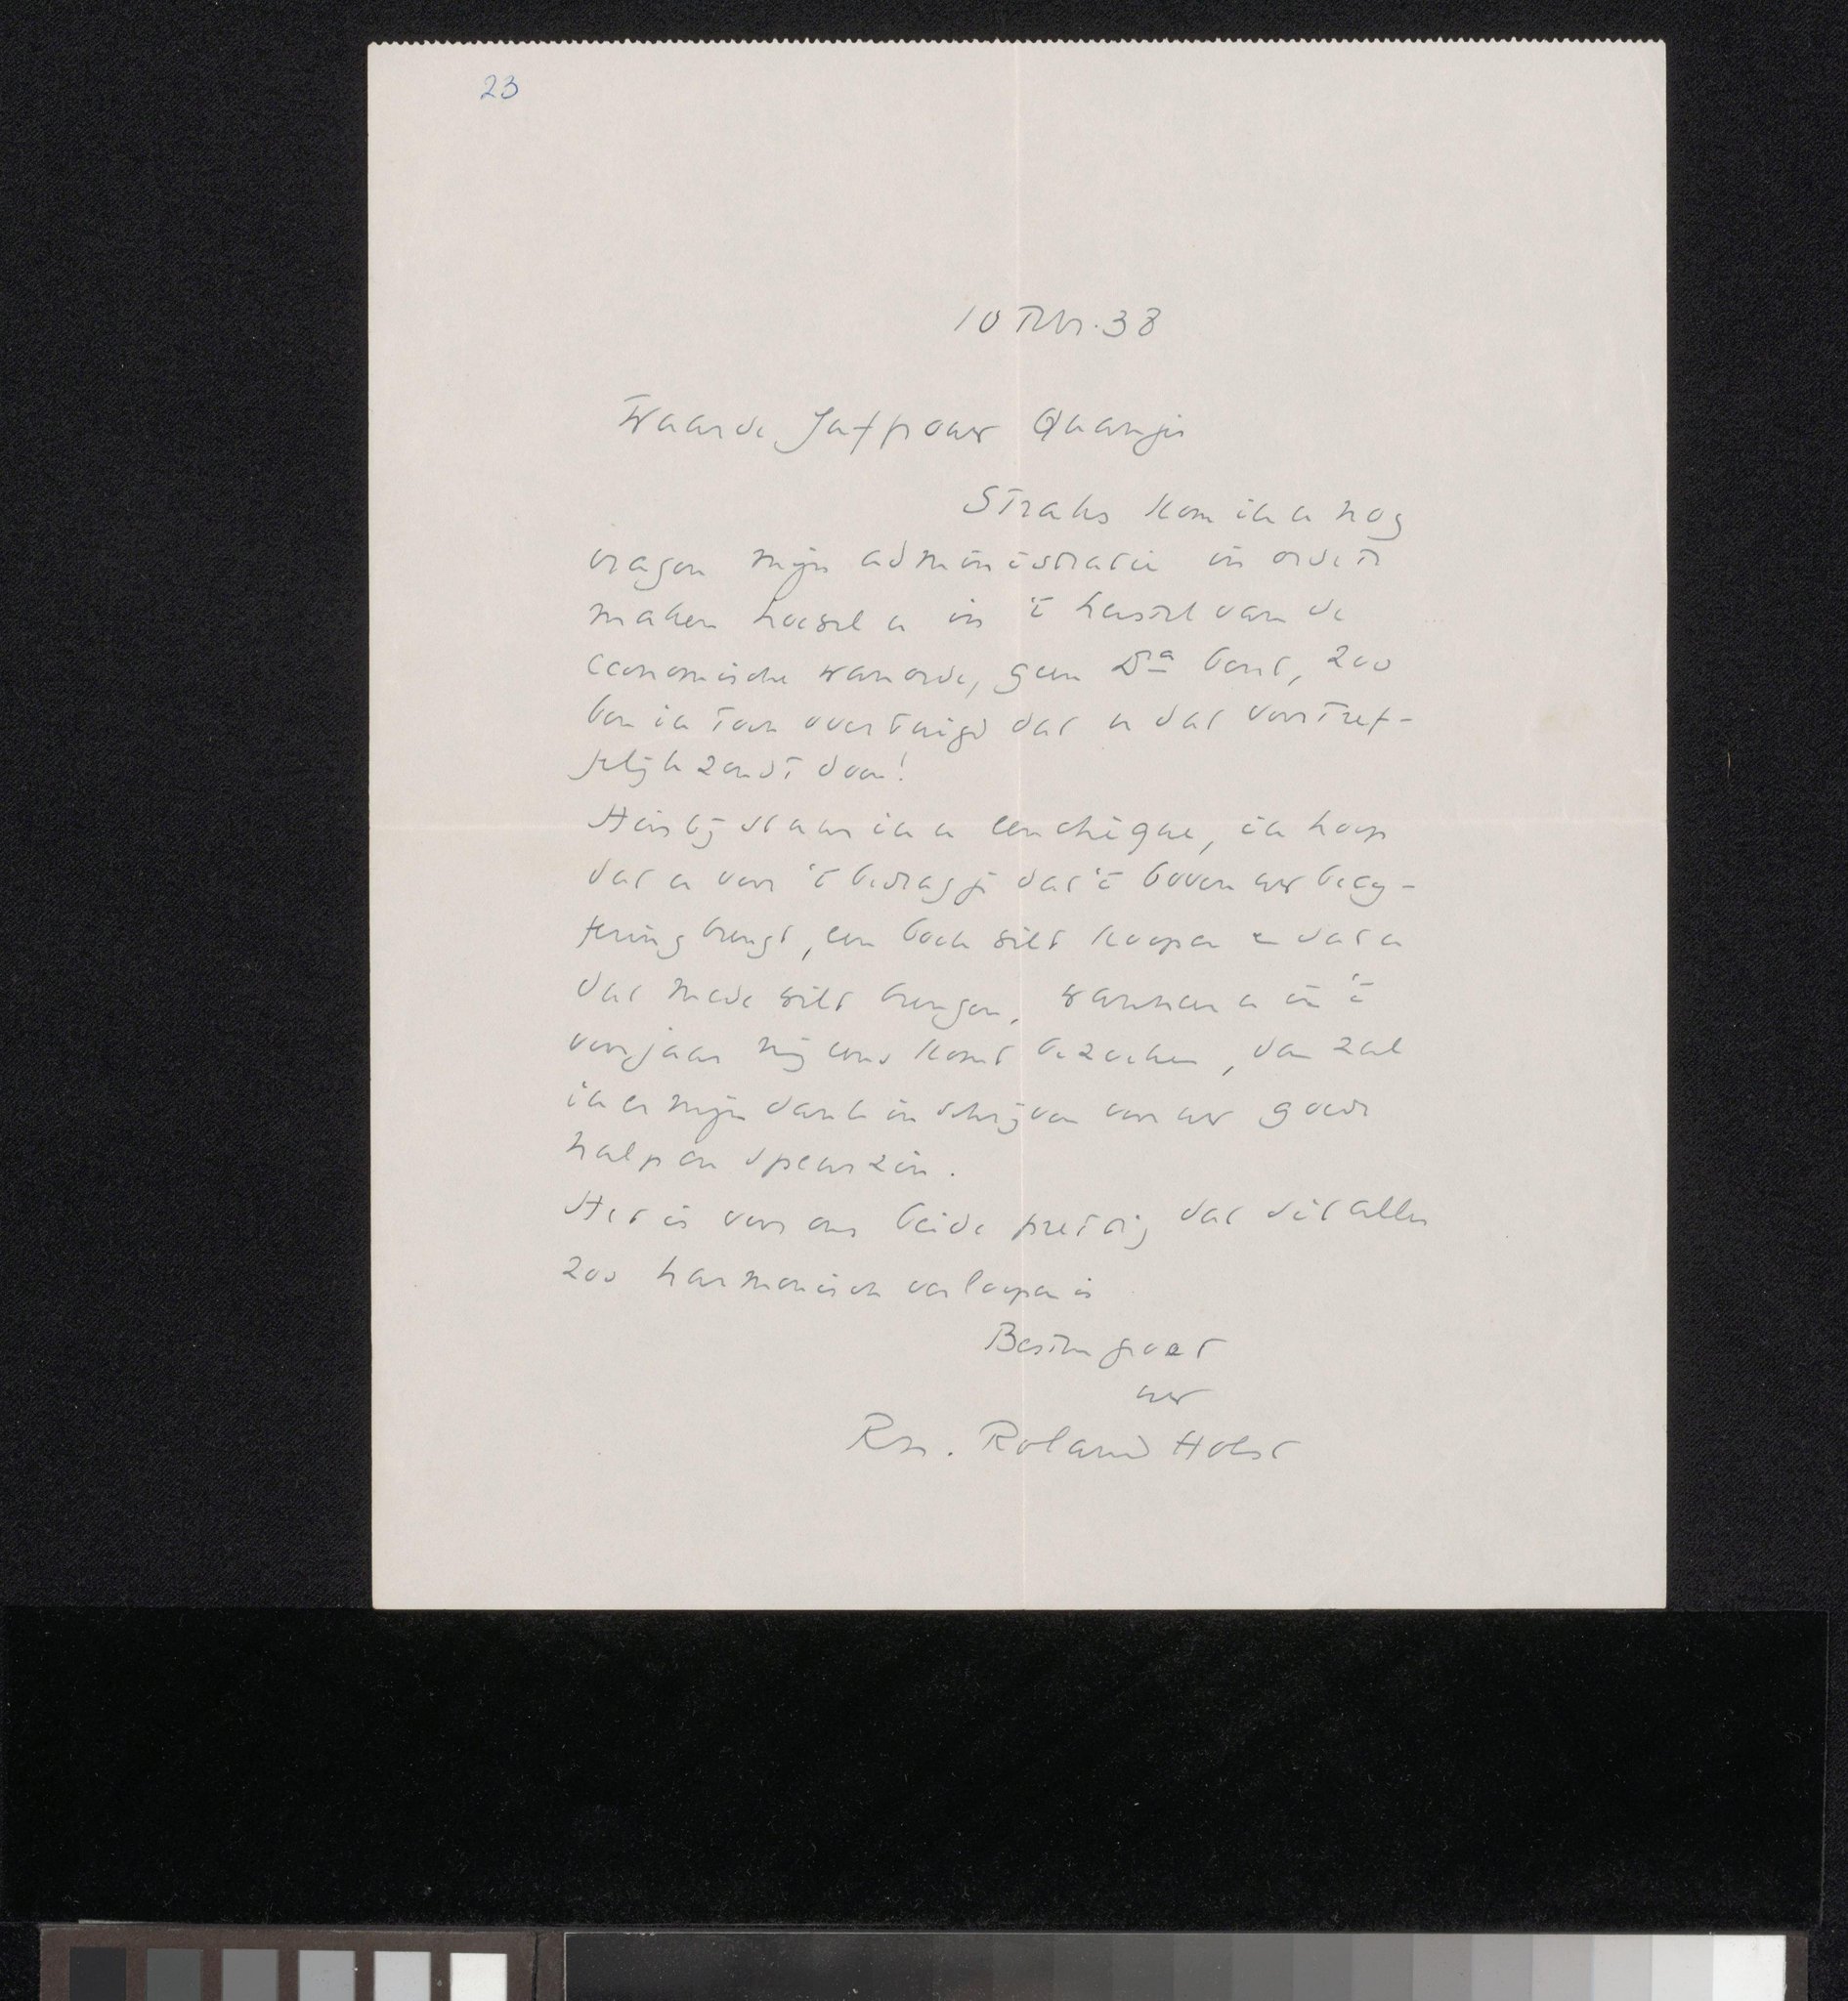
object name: letter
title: Brief aan Marisa Quanjer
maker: richard nicolaüs roland holst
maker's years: 1868-1938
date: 1938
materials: ink, paper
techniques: pen, writing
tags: money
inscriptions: collector's mark: ‘RPK’